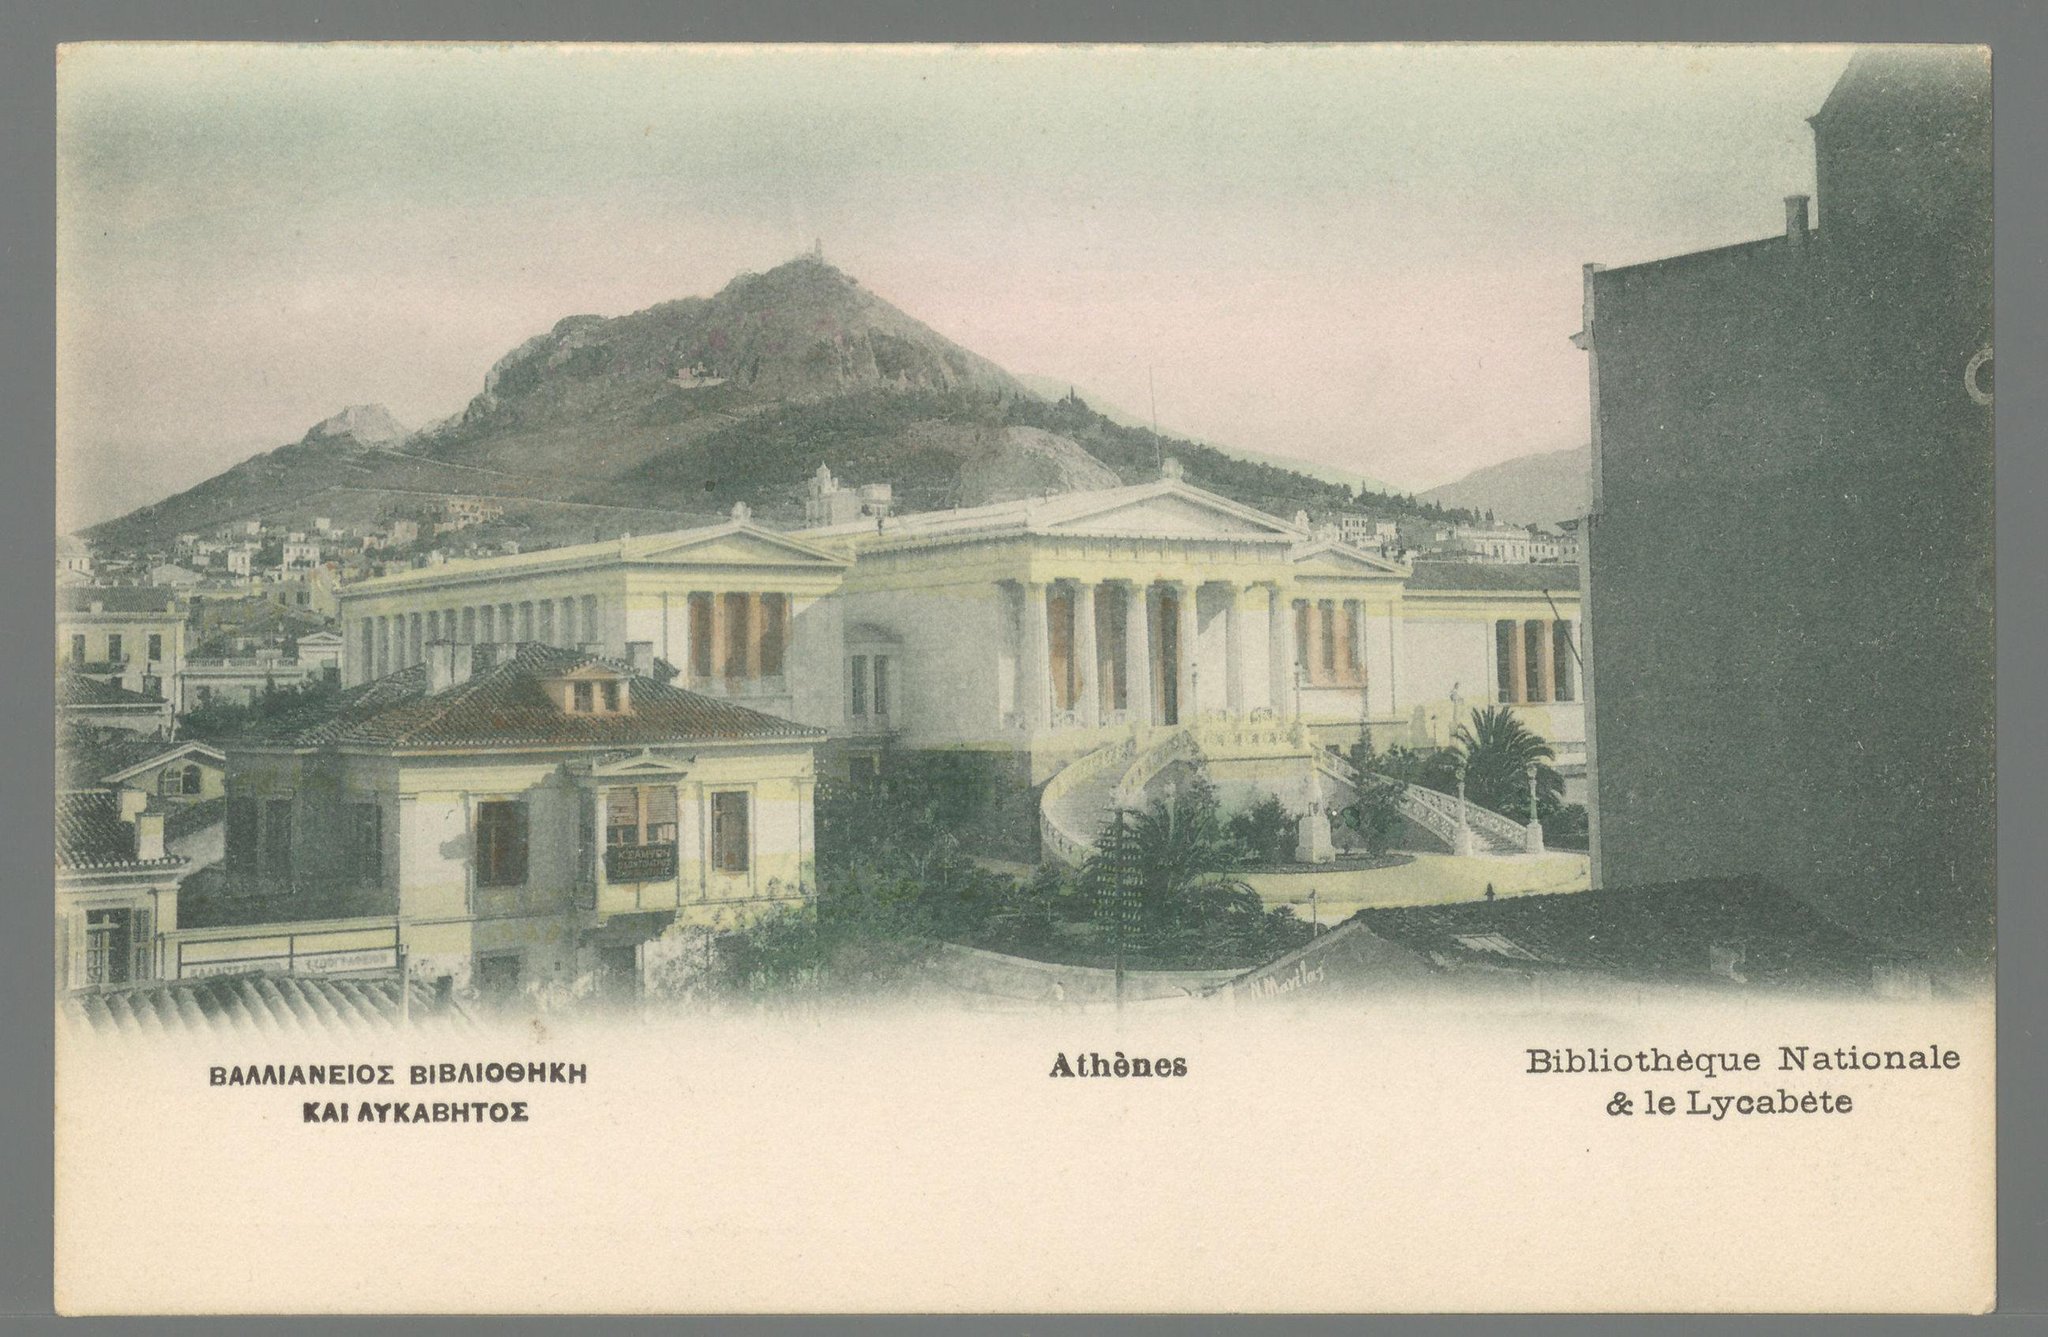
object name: ansichtkaart, prentbriefkaart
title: Athènes. Bibliothèque Nationale & le Lycabète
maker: Anonymous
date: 1906-1930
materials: cardboard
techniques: photograph, hand coloring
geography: athens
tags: public library, mountains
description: Voor de Franse titel staat de titel in het Grieks.